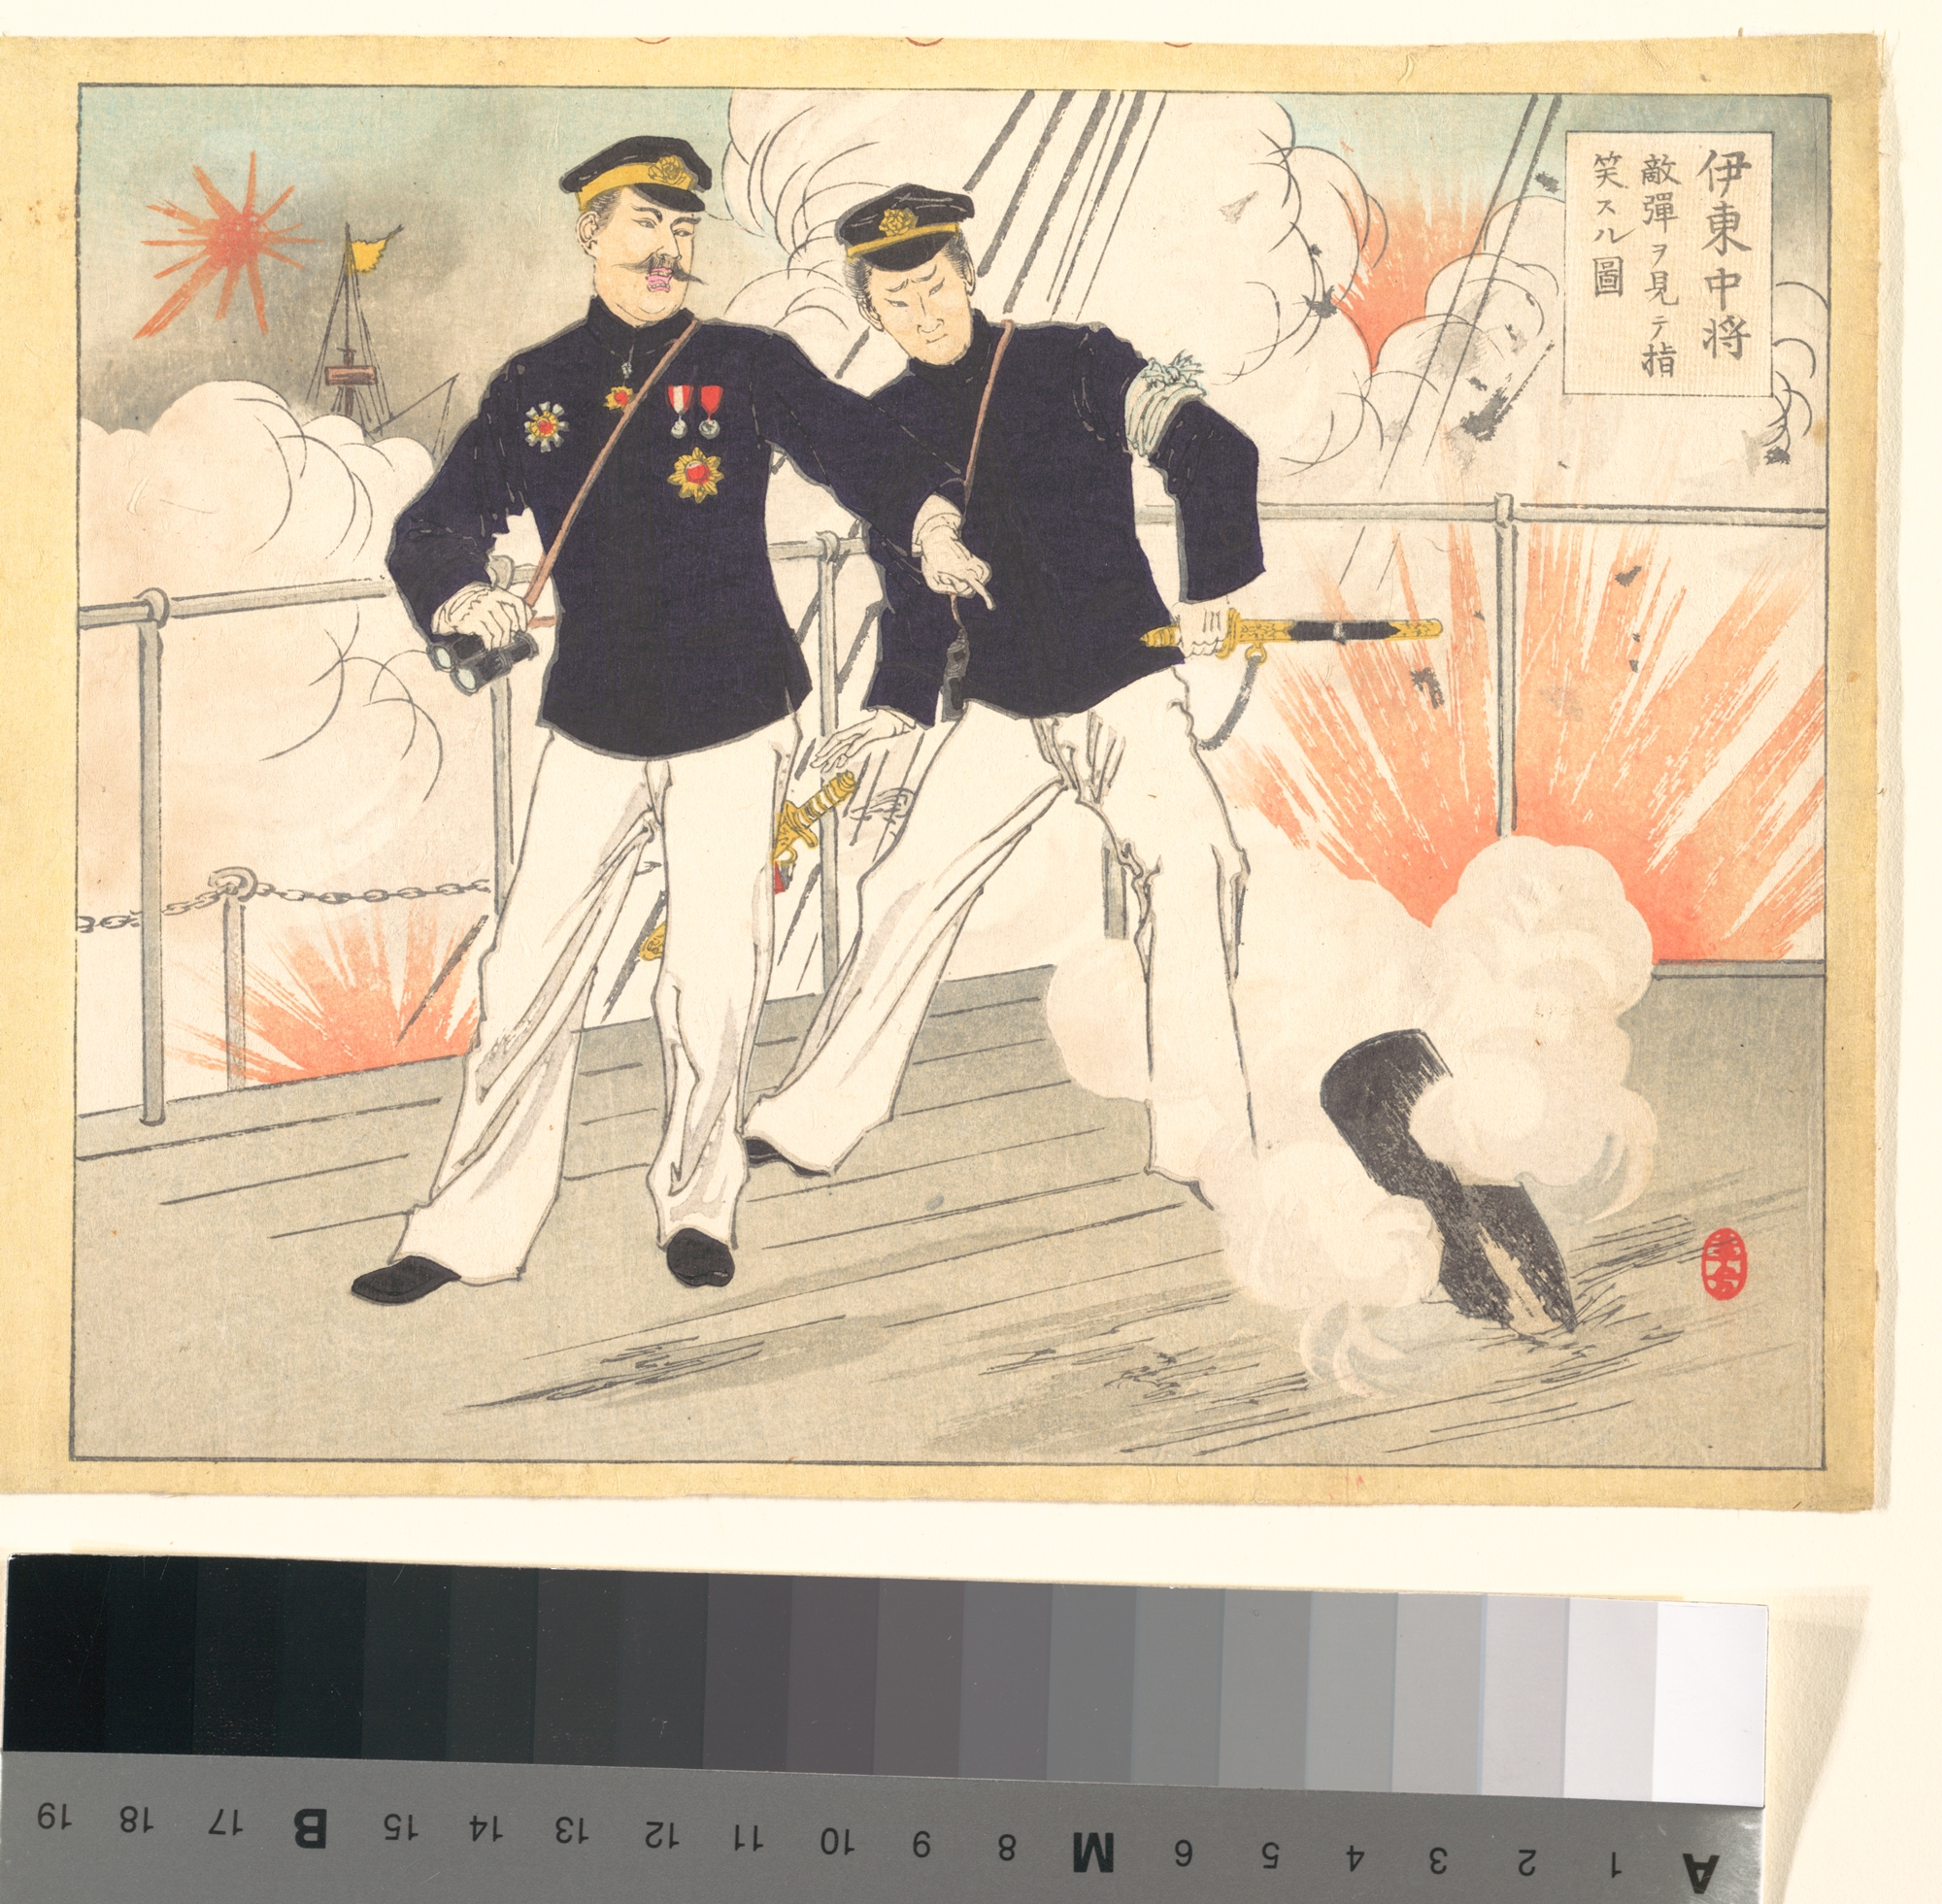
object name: print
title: Vice Admiral Ito Mocks, Points and Looks at the Enemy Bullets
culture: japanese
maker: mizuno toshikata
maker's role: artist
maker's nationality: japanese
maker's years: 1866-1908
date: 1894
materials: ink, paper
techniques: woodblock print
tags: navy,men